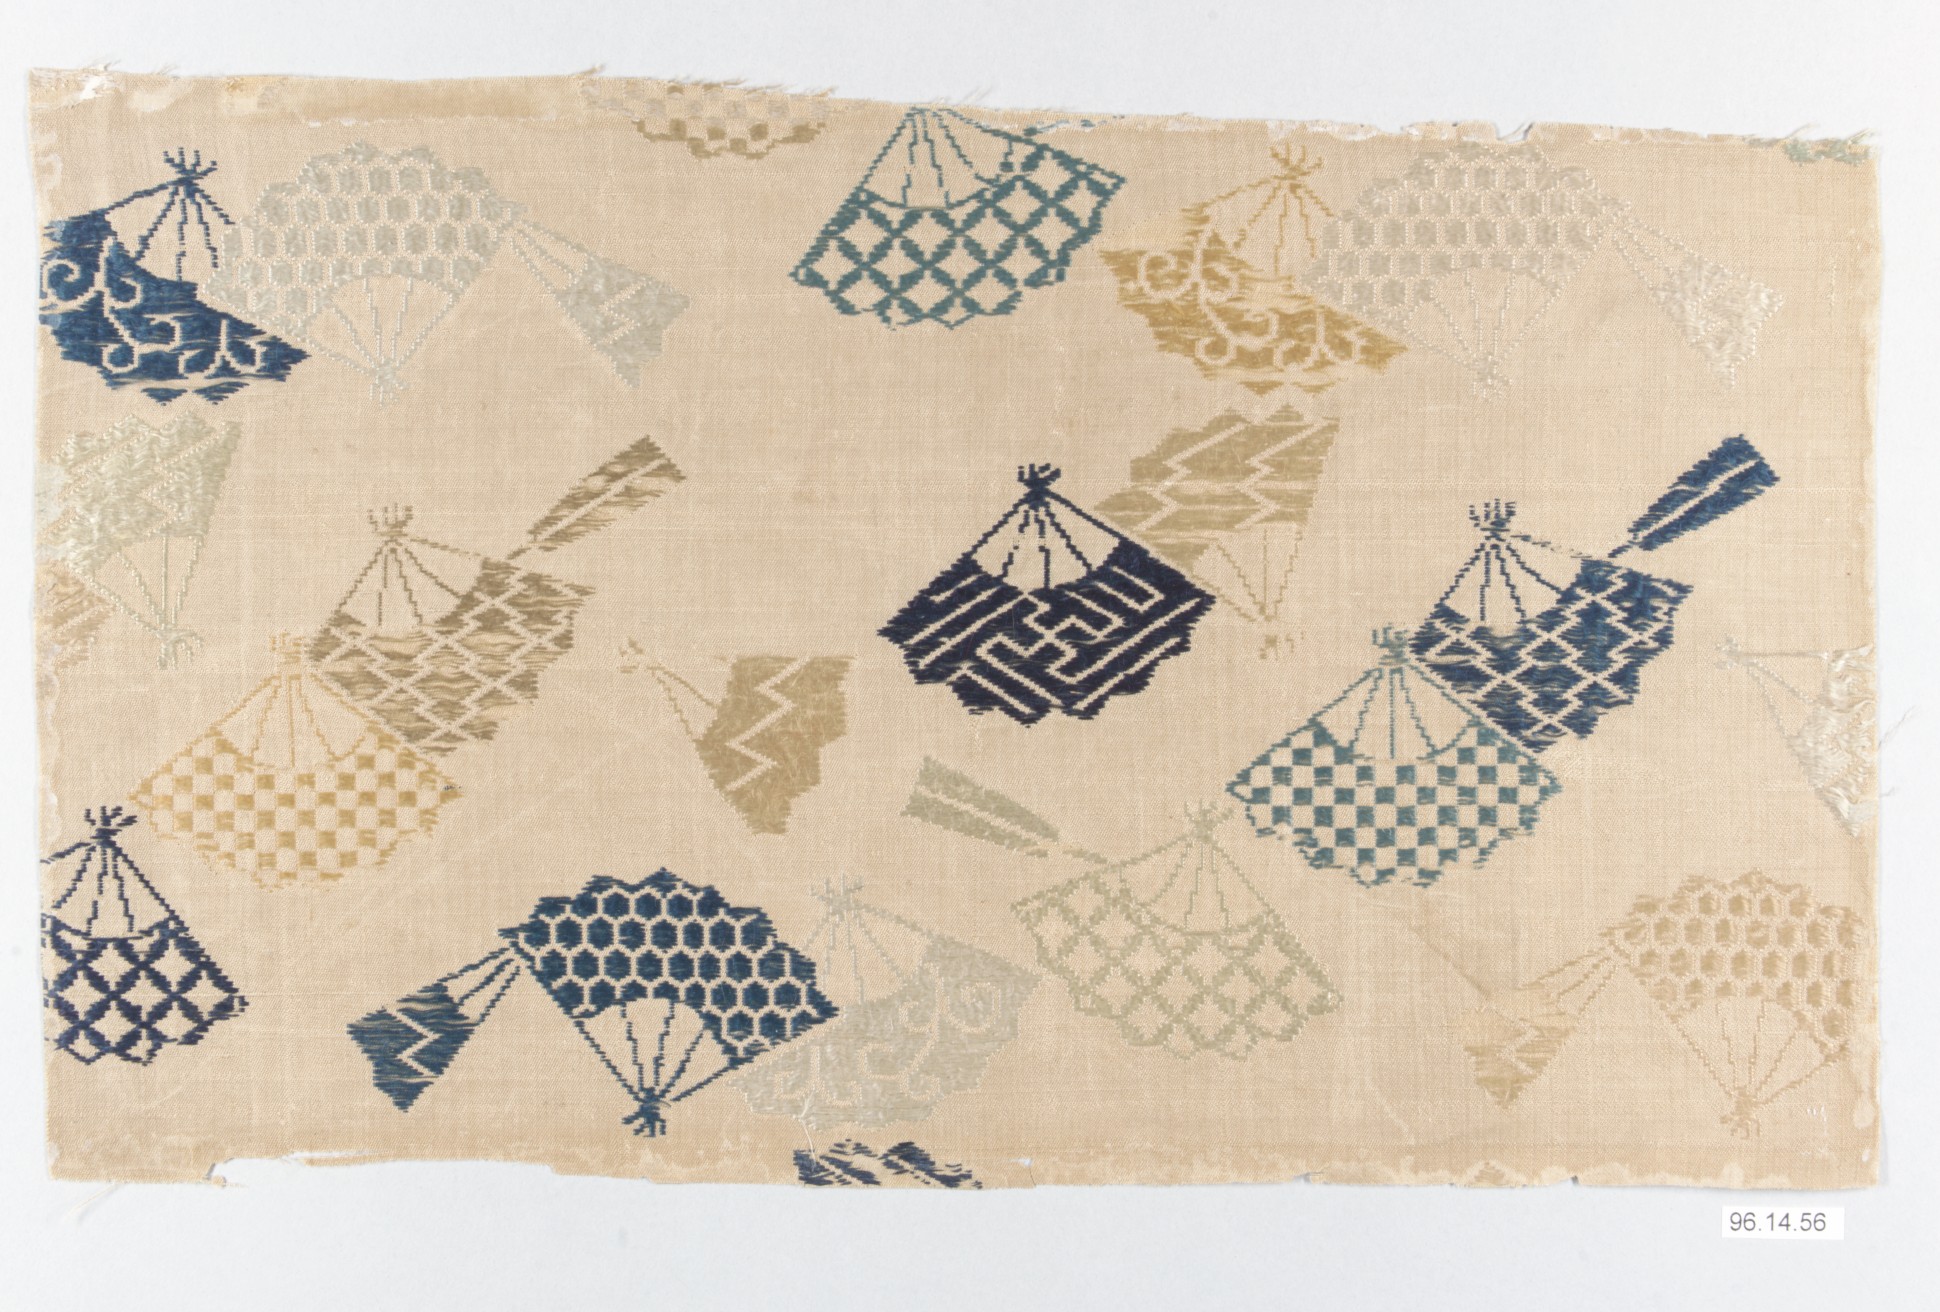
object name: piece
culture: japanese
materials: silk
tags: fans